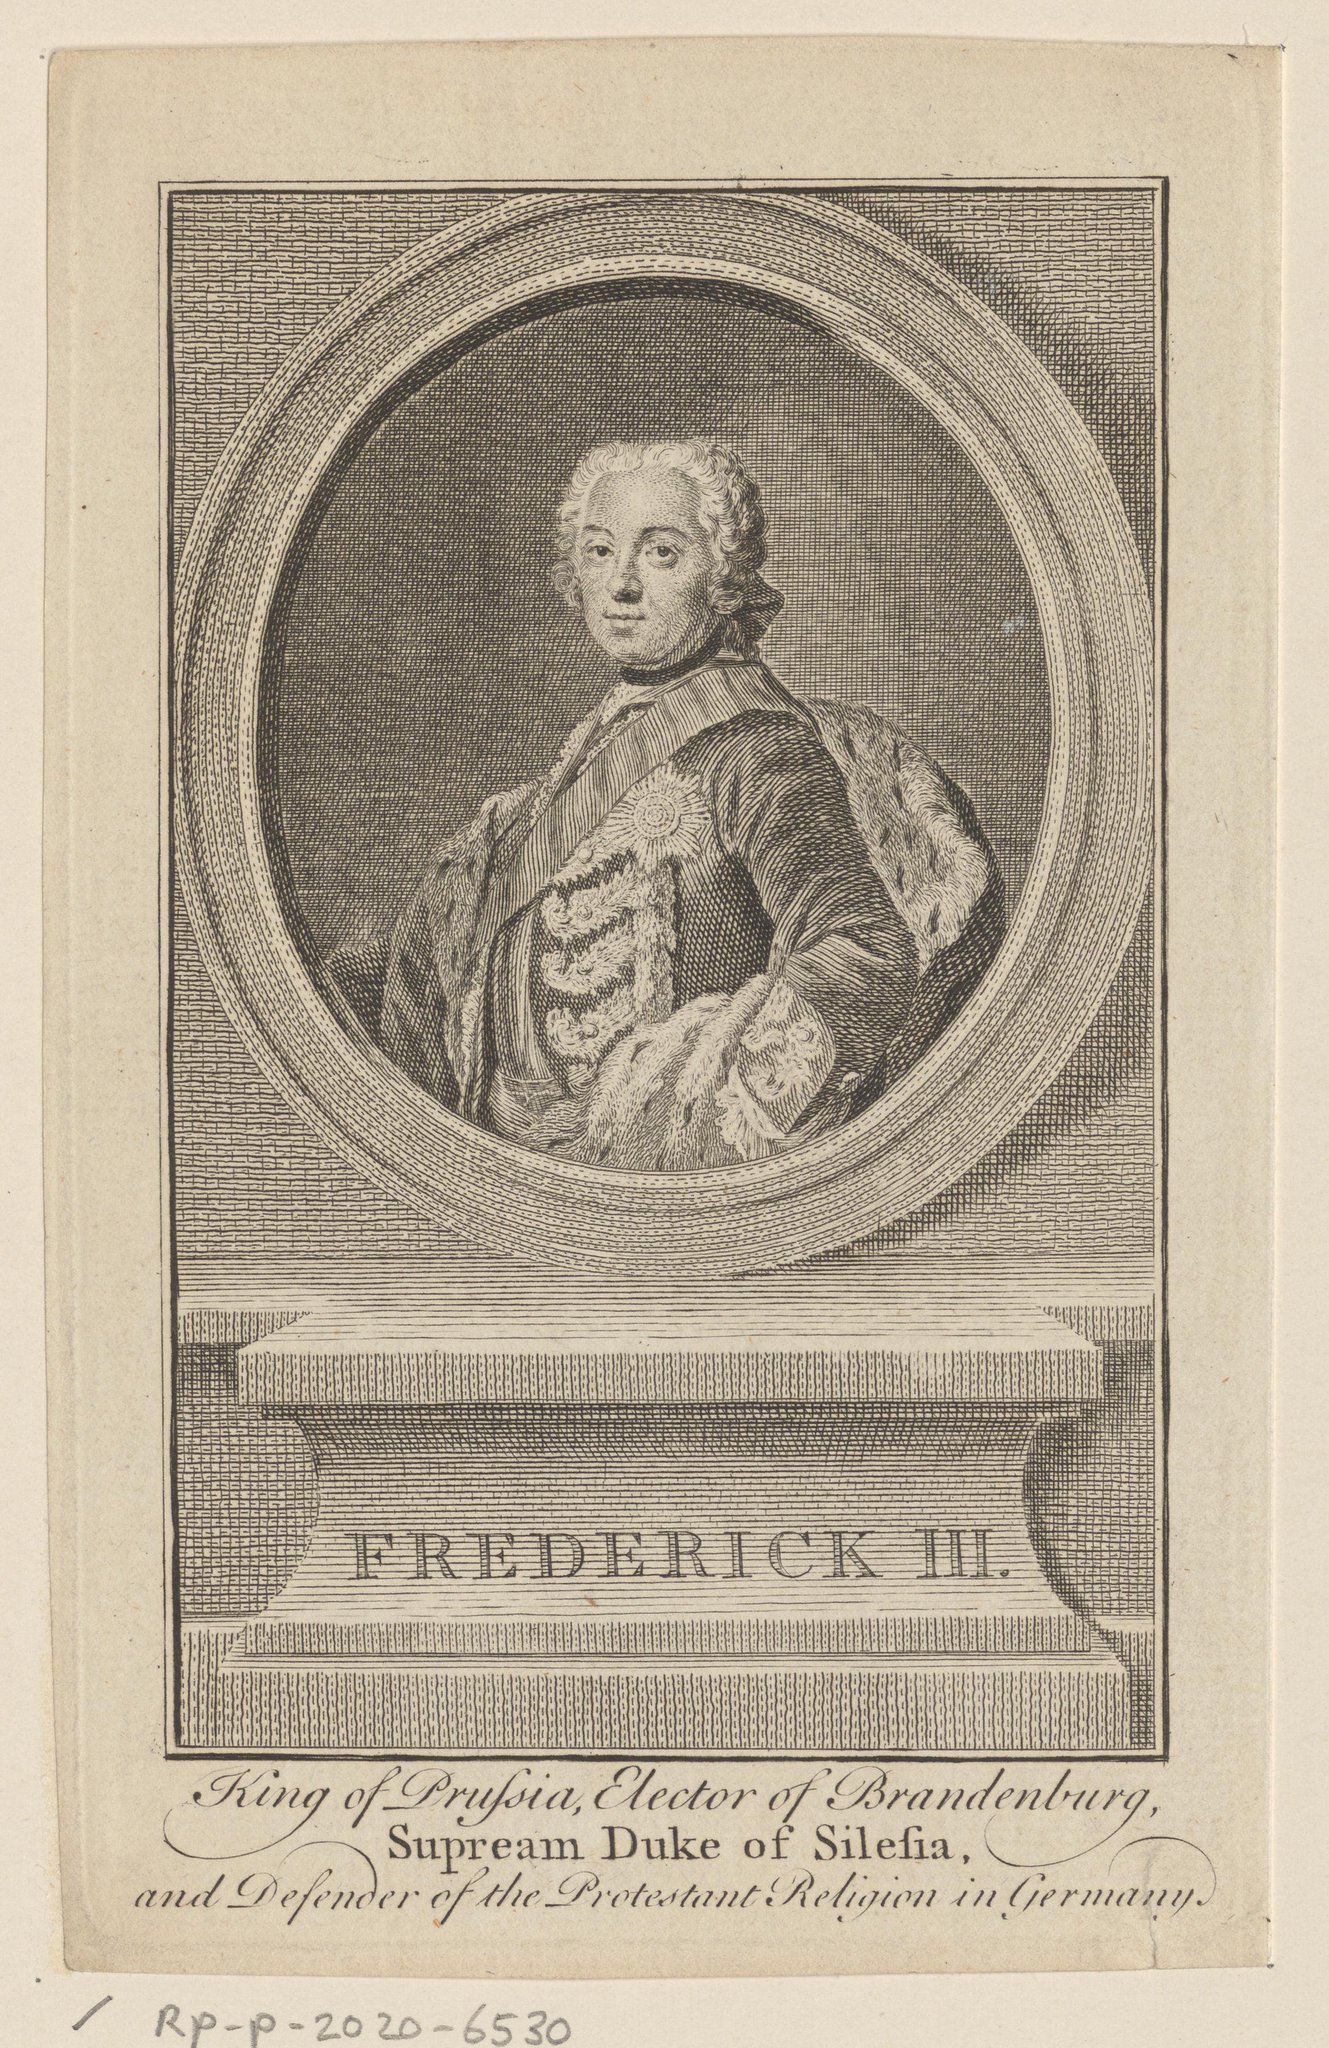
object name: print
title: Portret van Frederik de Grote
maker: Anonymous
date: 1740-1799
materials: paper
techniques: etching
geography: england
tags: berlin, frederick ii (king of prussia), ornament ~ medallion, historical persons, king